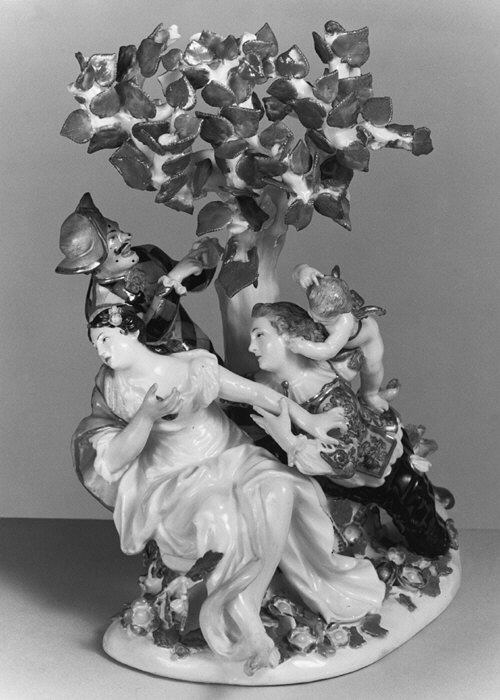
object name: group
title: Impetuous Lover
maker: meissen manufactory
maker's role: manufactory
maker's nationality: german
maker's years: 1710-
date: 1743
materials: hard paste porcelain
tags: men,women,cupid,trees